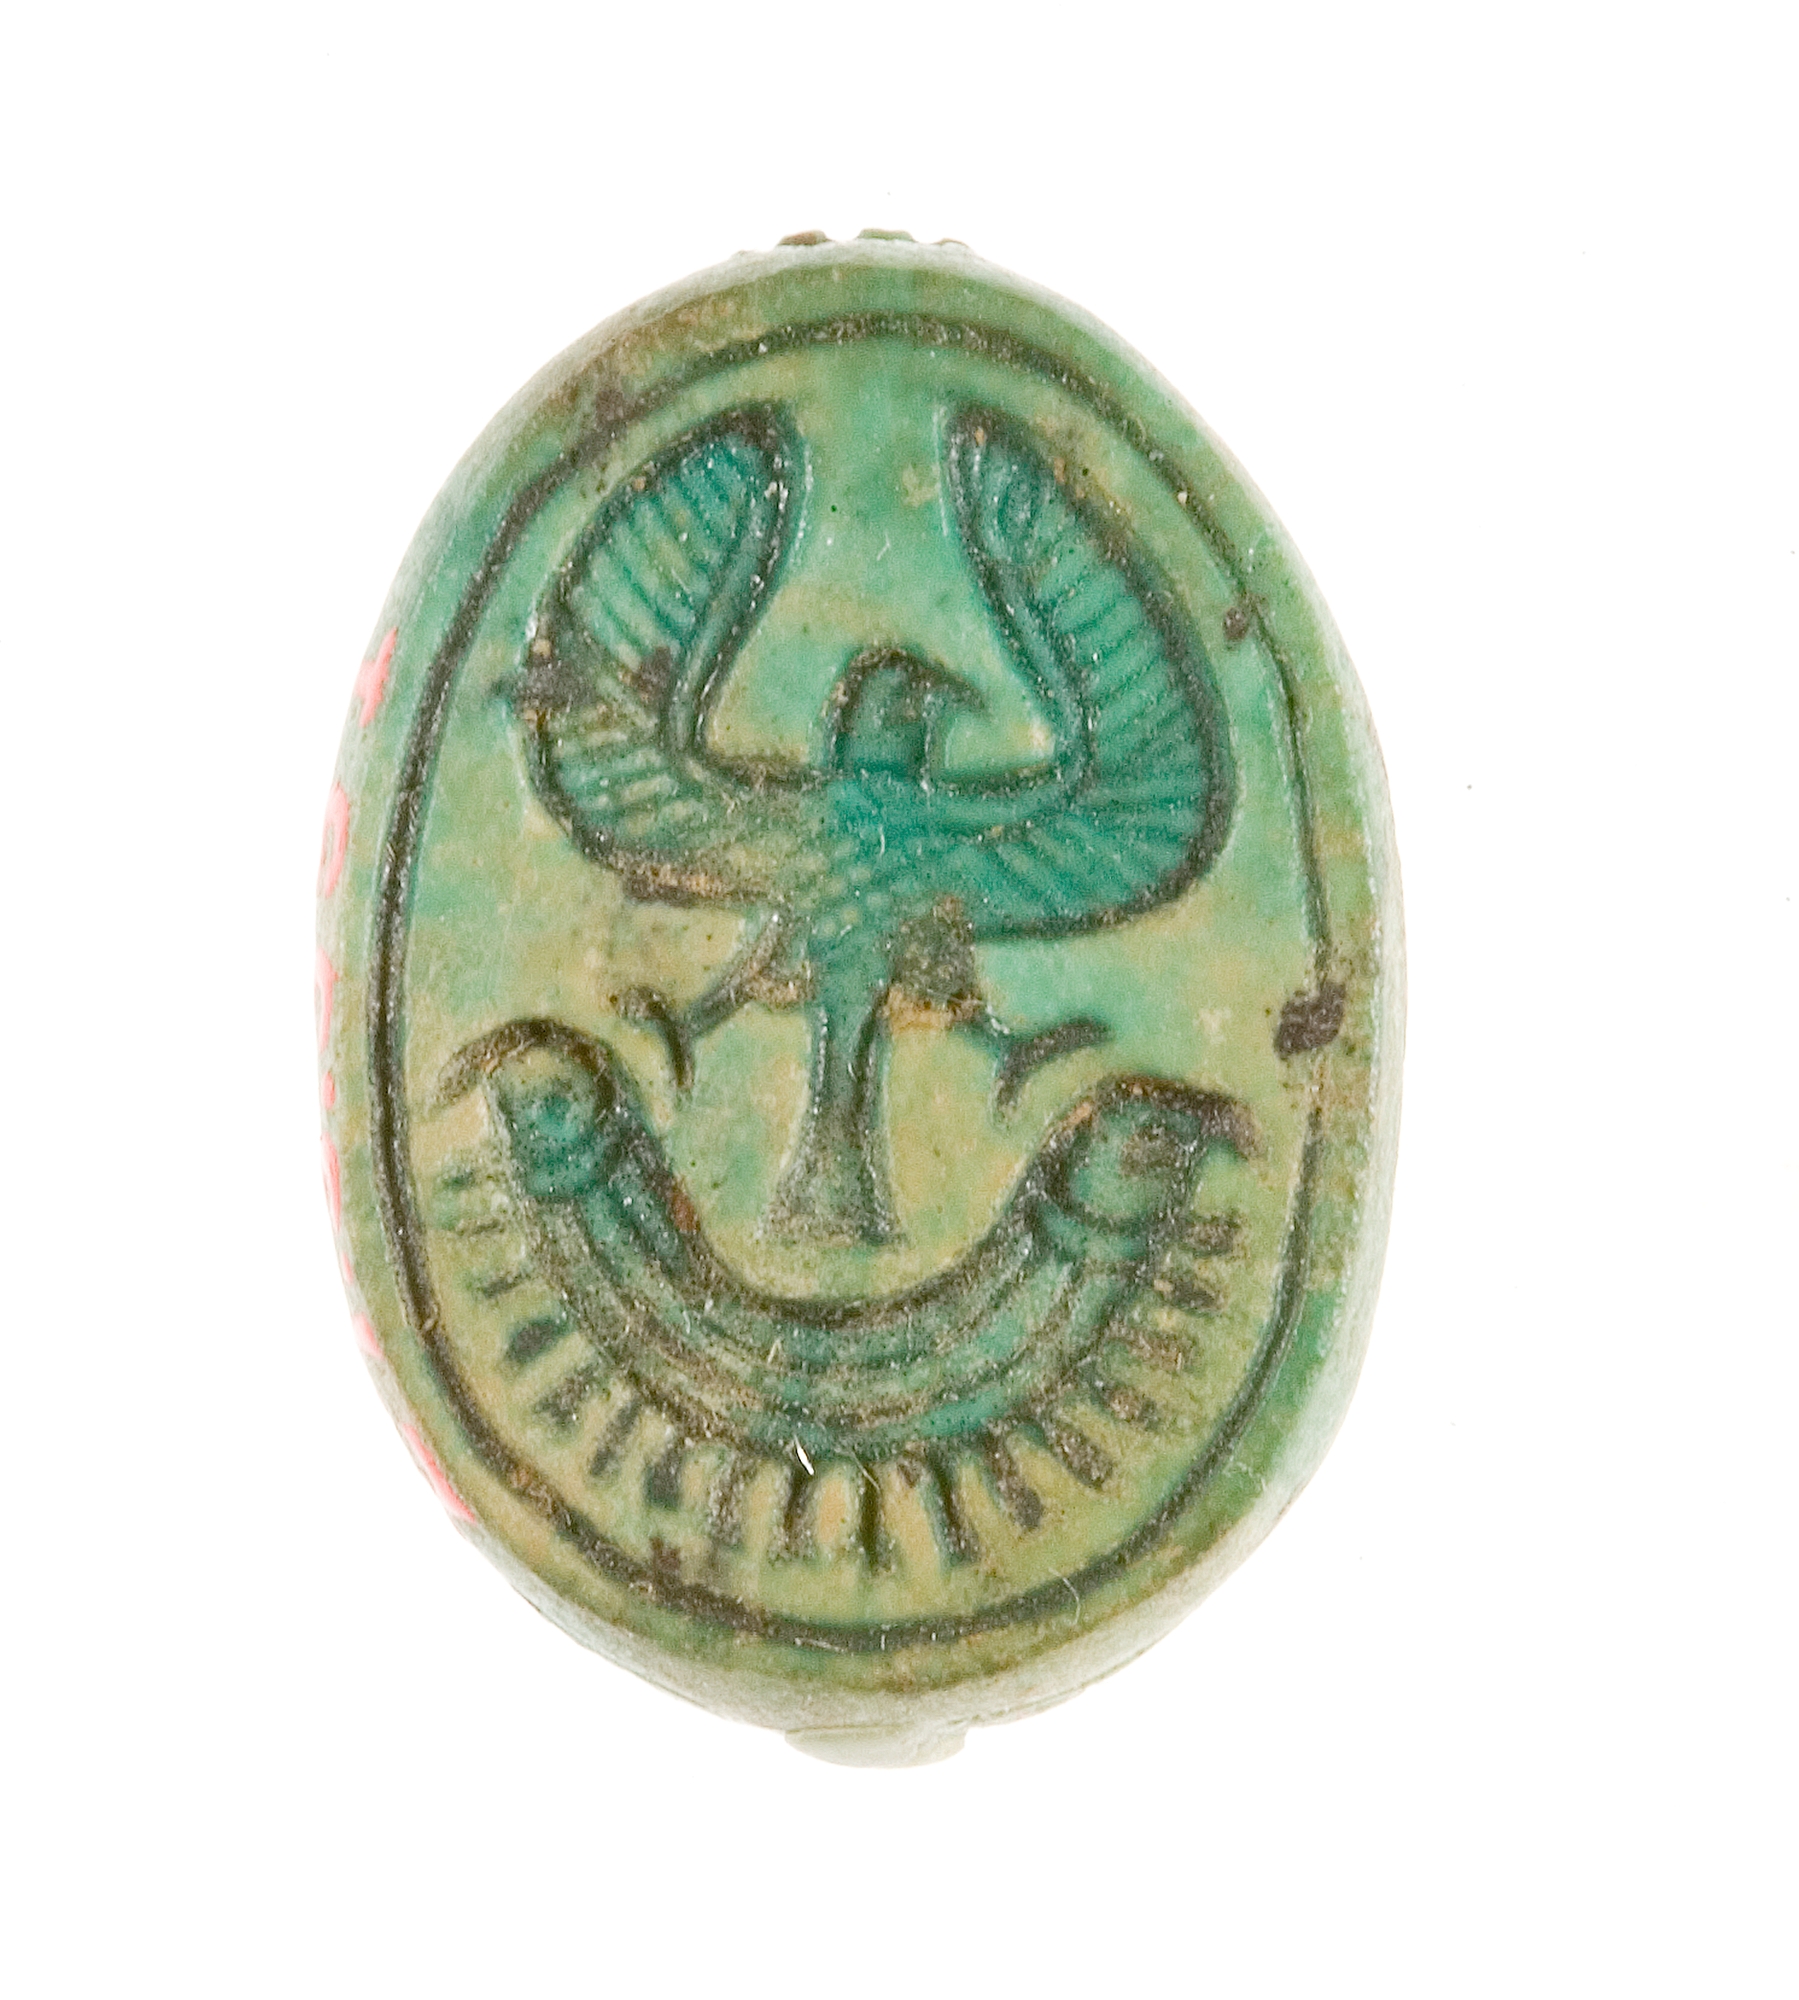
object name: scarab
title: Scarab Inscribed with a Hieroglyphic Motif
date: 1479-1458 BCE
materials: stone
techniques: glazing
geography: egypt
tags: birds,hieroglyphs,scarabs